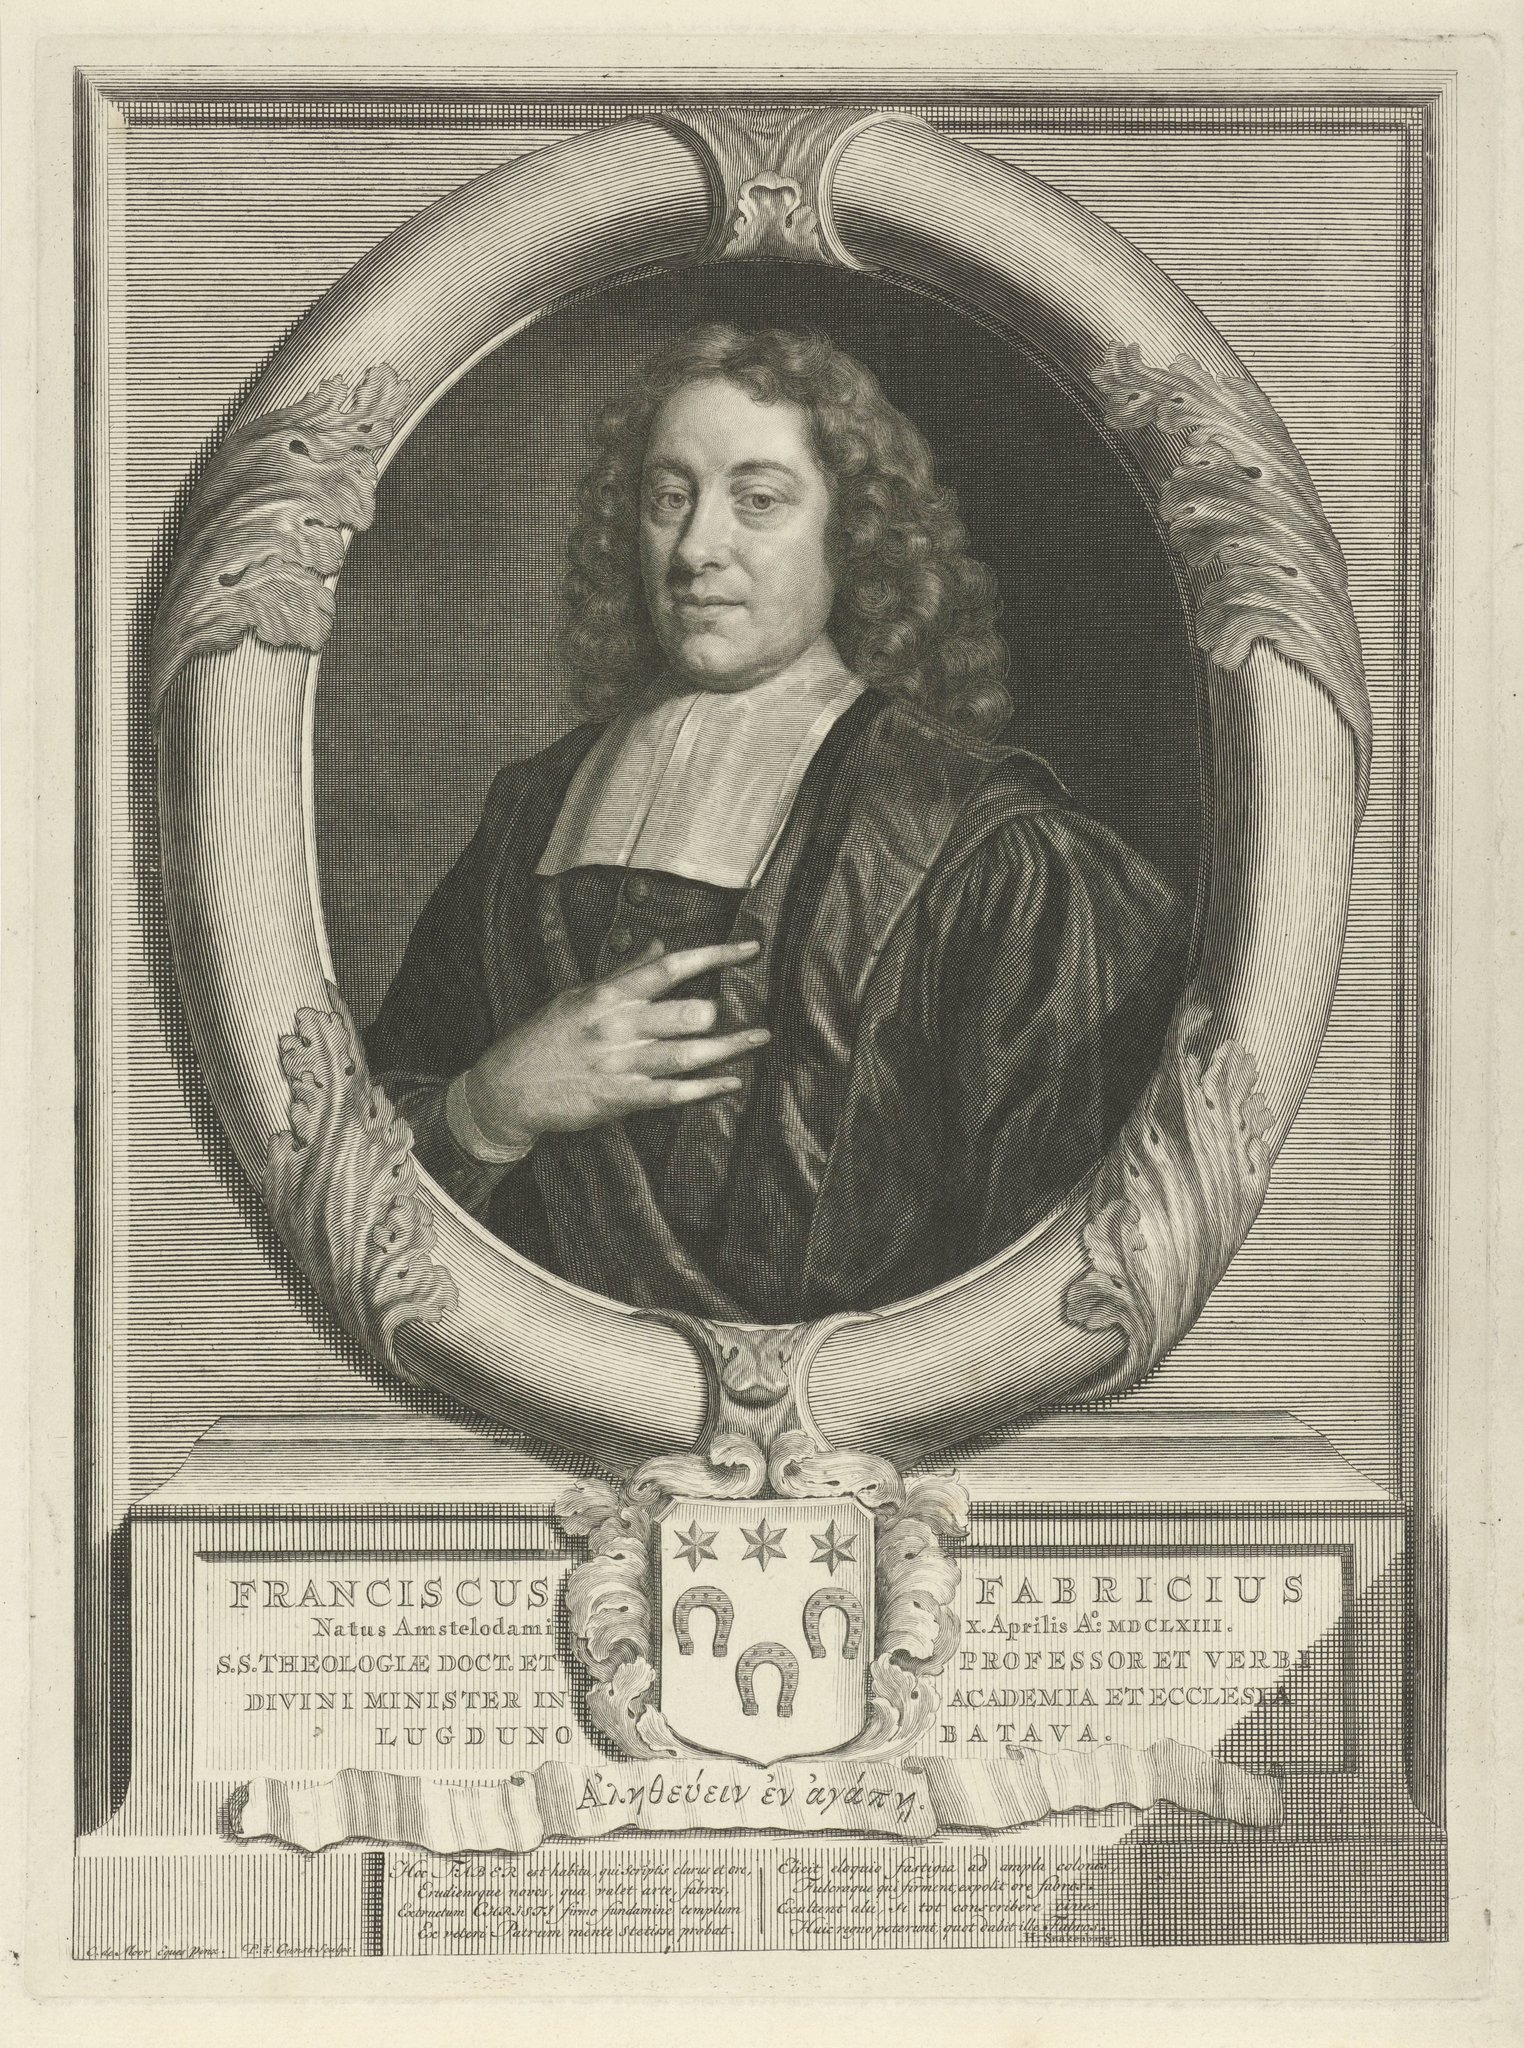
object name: print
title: Portret van Franciscus Fabricius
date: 1694-1731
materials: paper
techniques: engraving, etching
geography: amsterdam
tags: amsterdam, leiden, franciscus fabricius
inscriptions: collector's mark: Lugt 240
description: Franciscus Fabricius, predikant en Hoogleraar theologie in Leiden. Onder het portret een wapenschild en als onderschrift een Latijns gedicht over zijn leven.